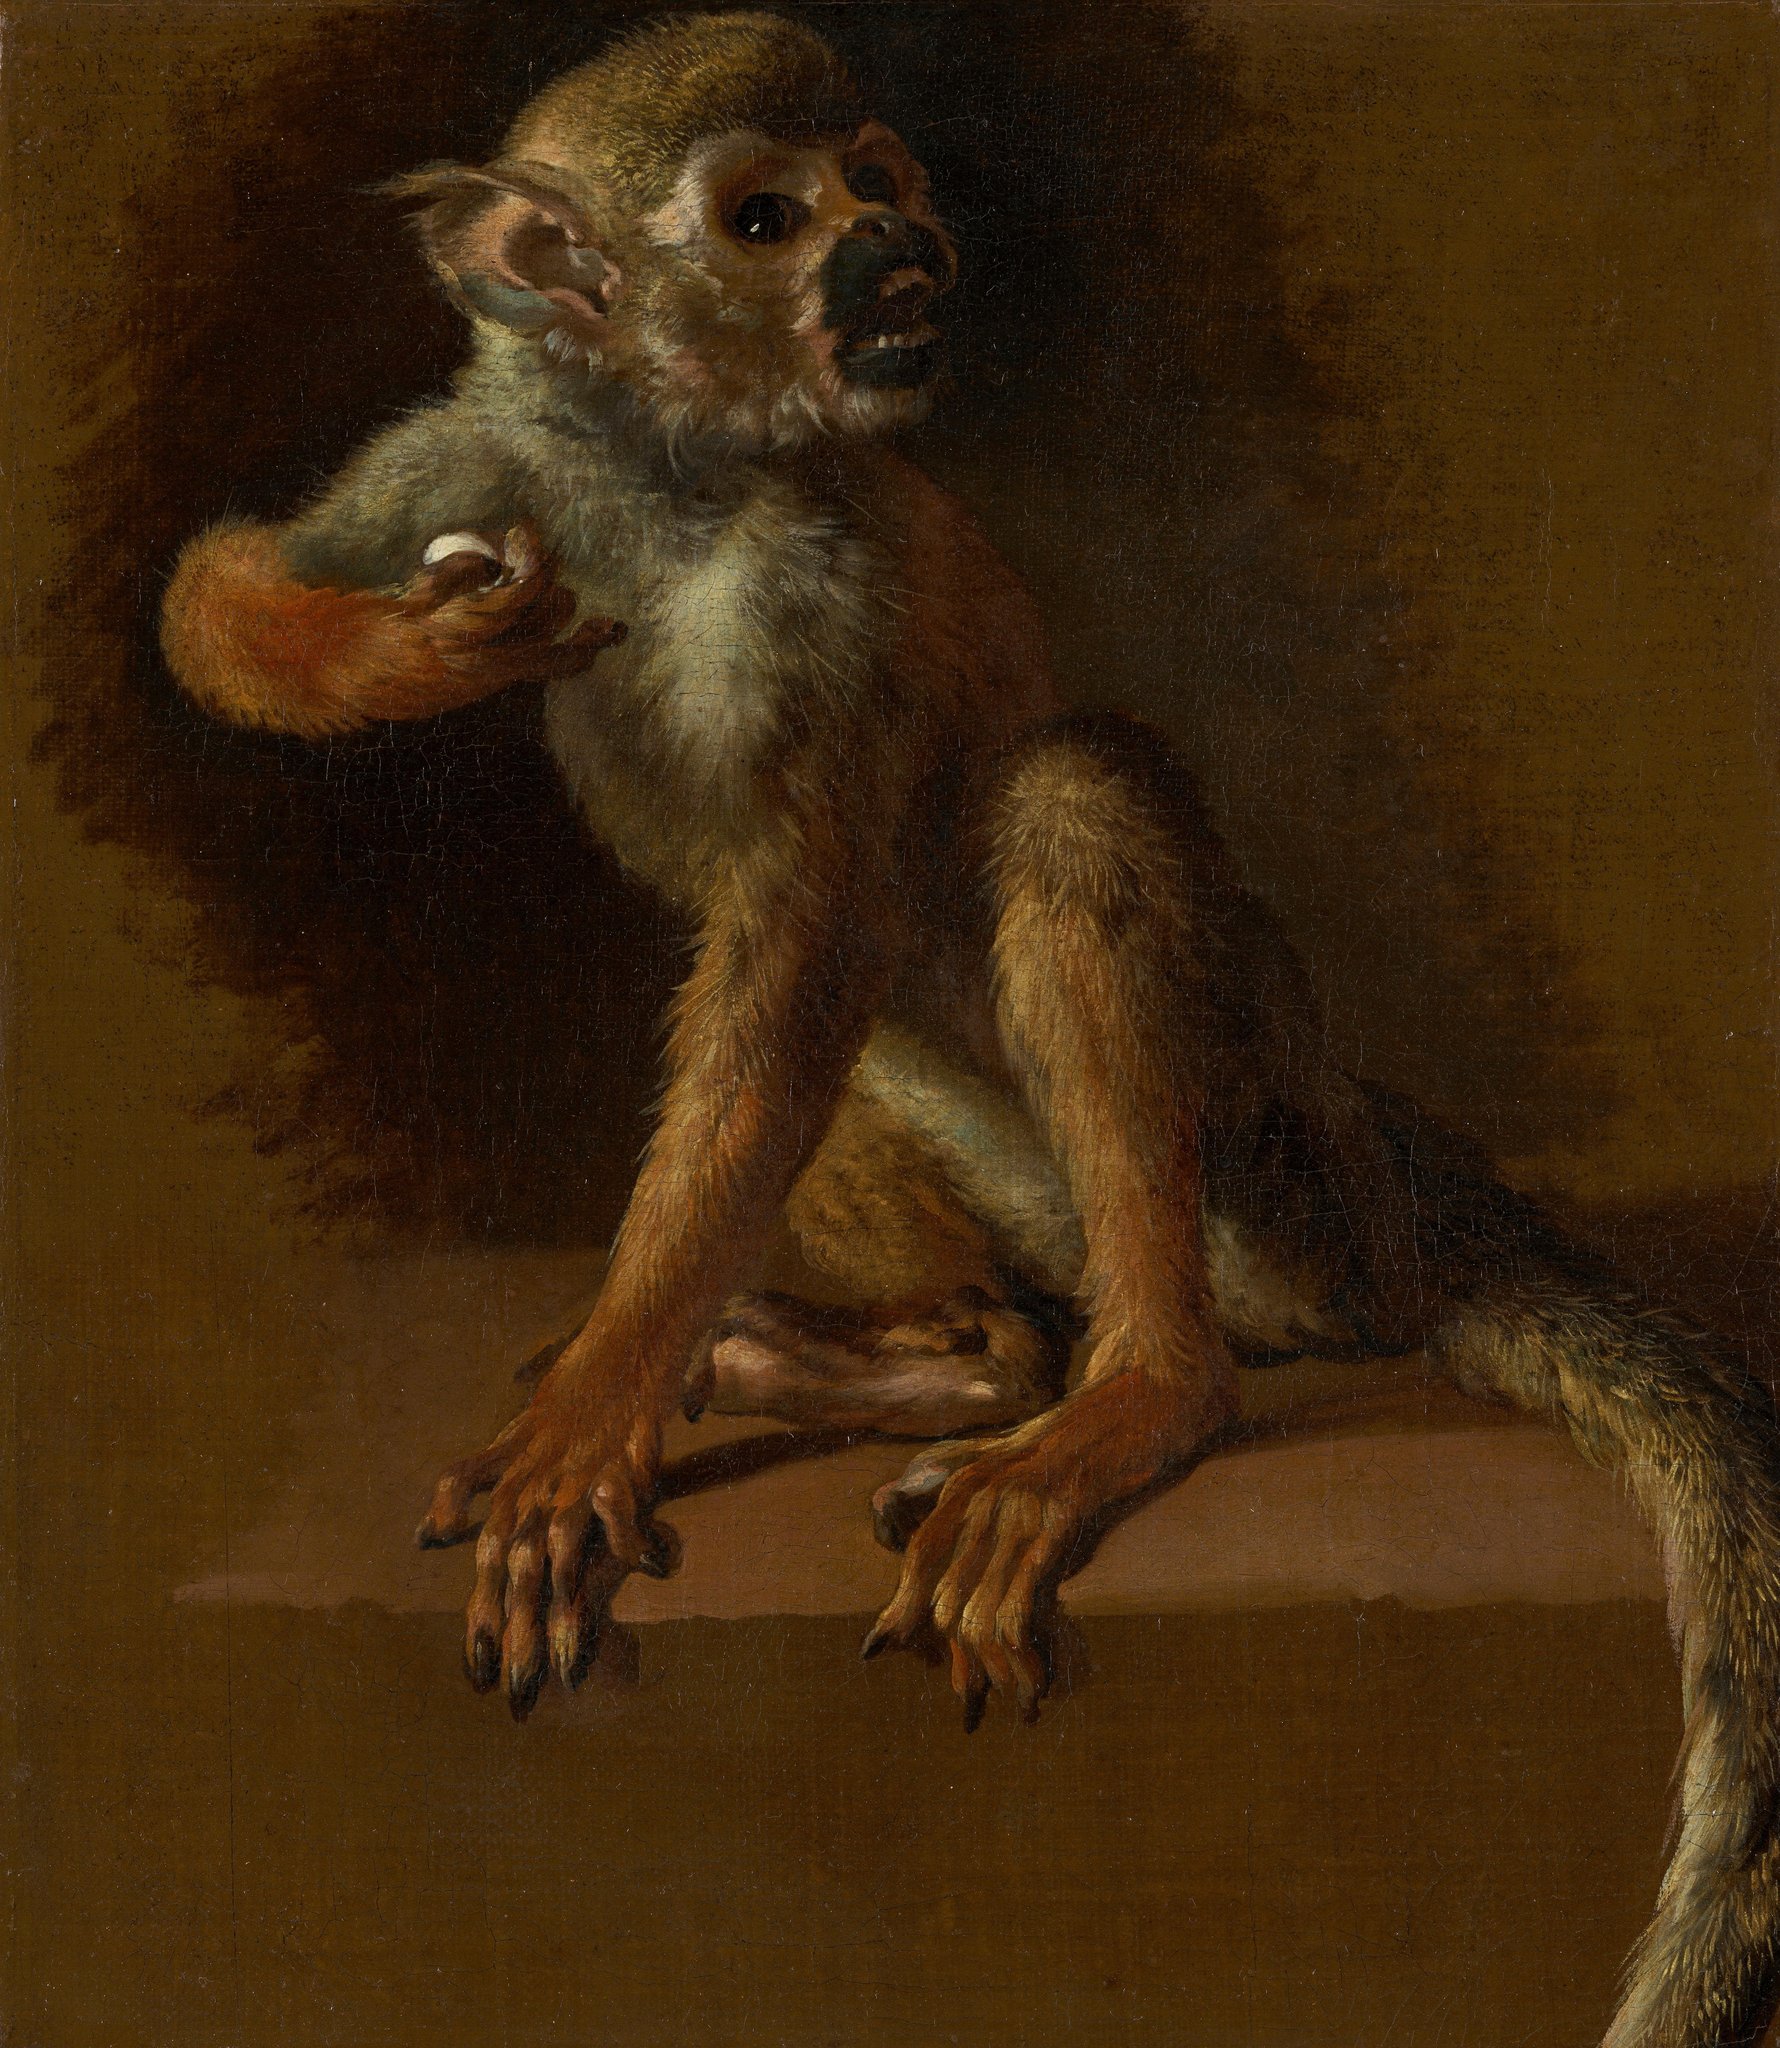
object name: painting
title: A Seated Monkey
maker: jan weenix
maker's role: draughtsman, painter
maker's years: 1640-1719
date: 1685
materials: canvas, oil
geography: amsterdam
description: Jan Weenix painted his animal pieces in a highly pragmatic fashion. For instance, once he had depicted this little monkey accurately from life, he could use the study over and over again. The Rijksmuseum owns two game still lifes clearly showing how he went about this: one is hanging next to this work. Weenix copied the monkey, as he did in many other paintings. This studio material allows us to follow his working method.